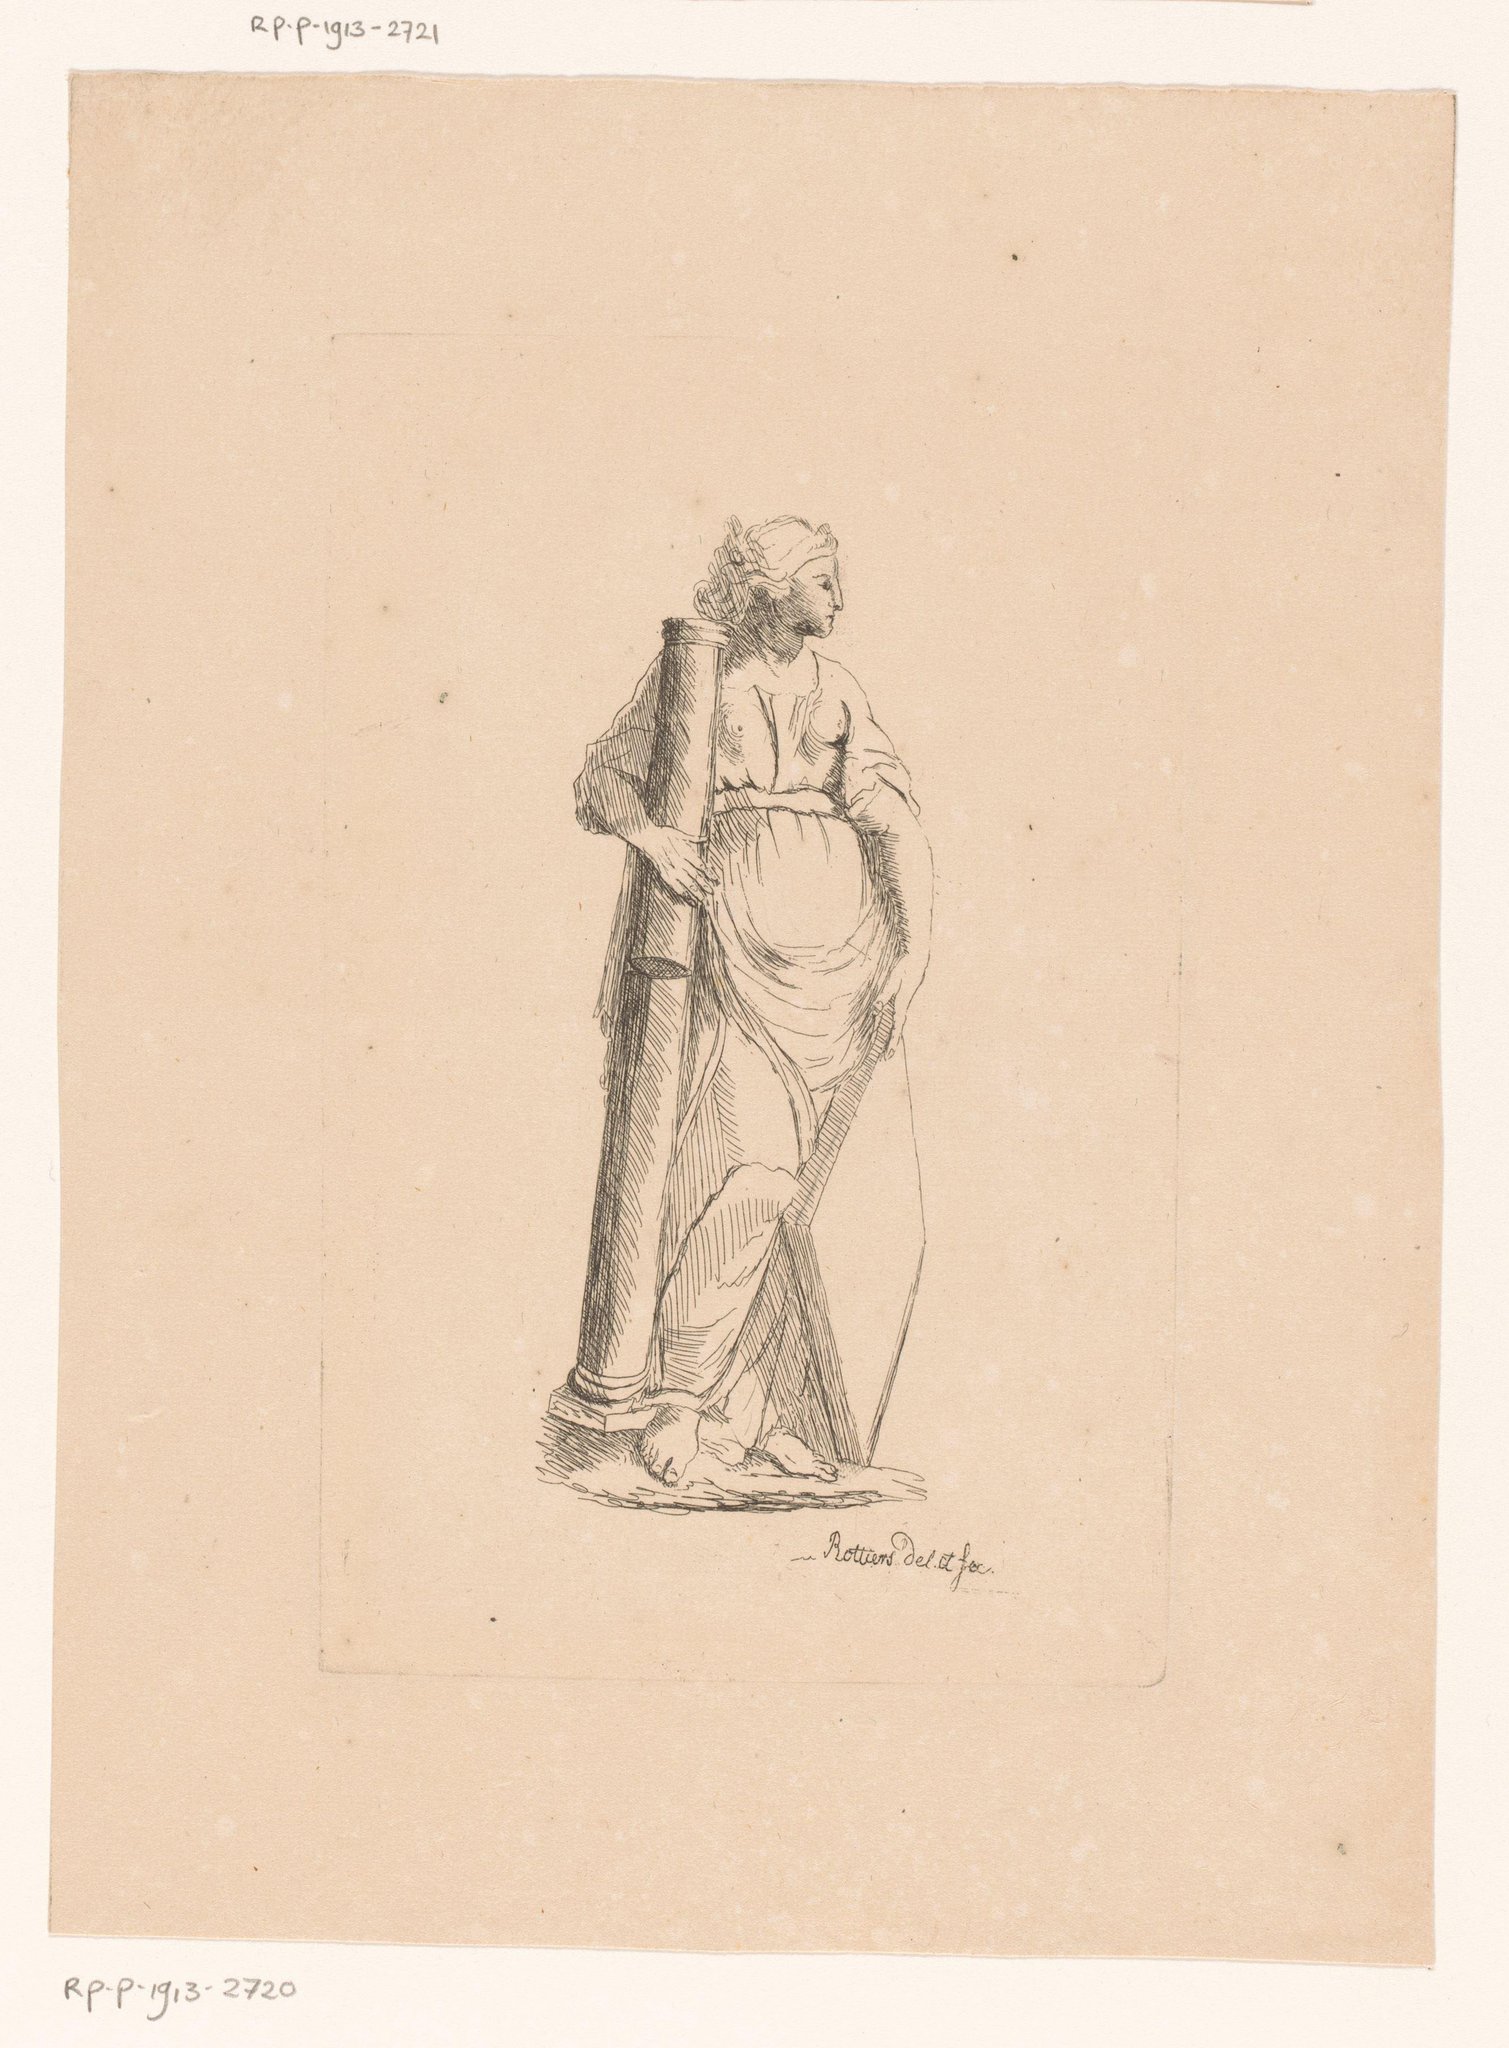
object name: print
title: Vrouwenfiguur met gebroken zuil en ruitvormig schild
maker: bernard eugène antoine rottiers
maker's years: 1771-1857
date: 1781-1858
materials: paper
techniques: etching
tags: adult woman, column, pillar ~ architecture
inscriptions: collector's mark: Lugt 2228